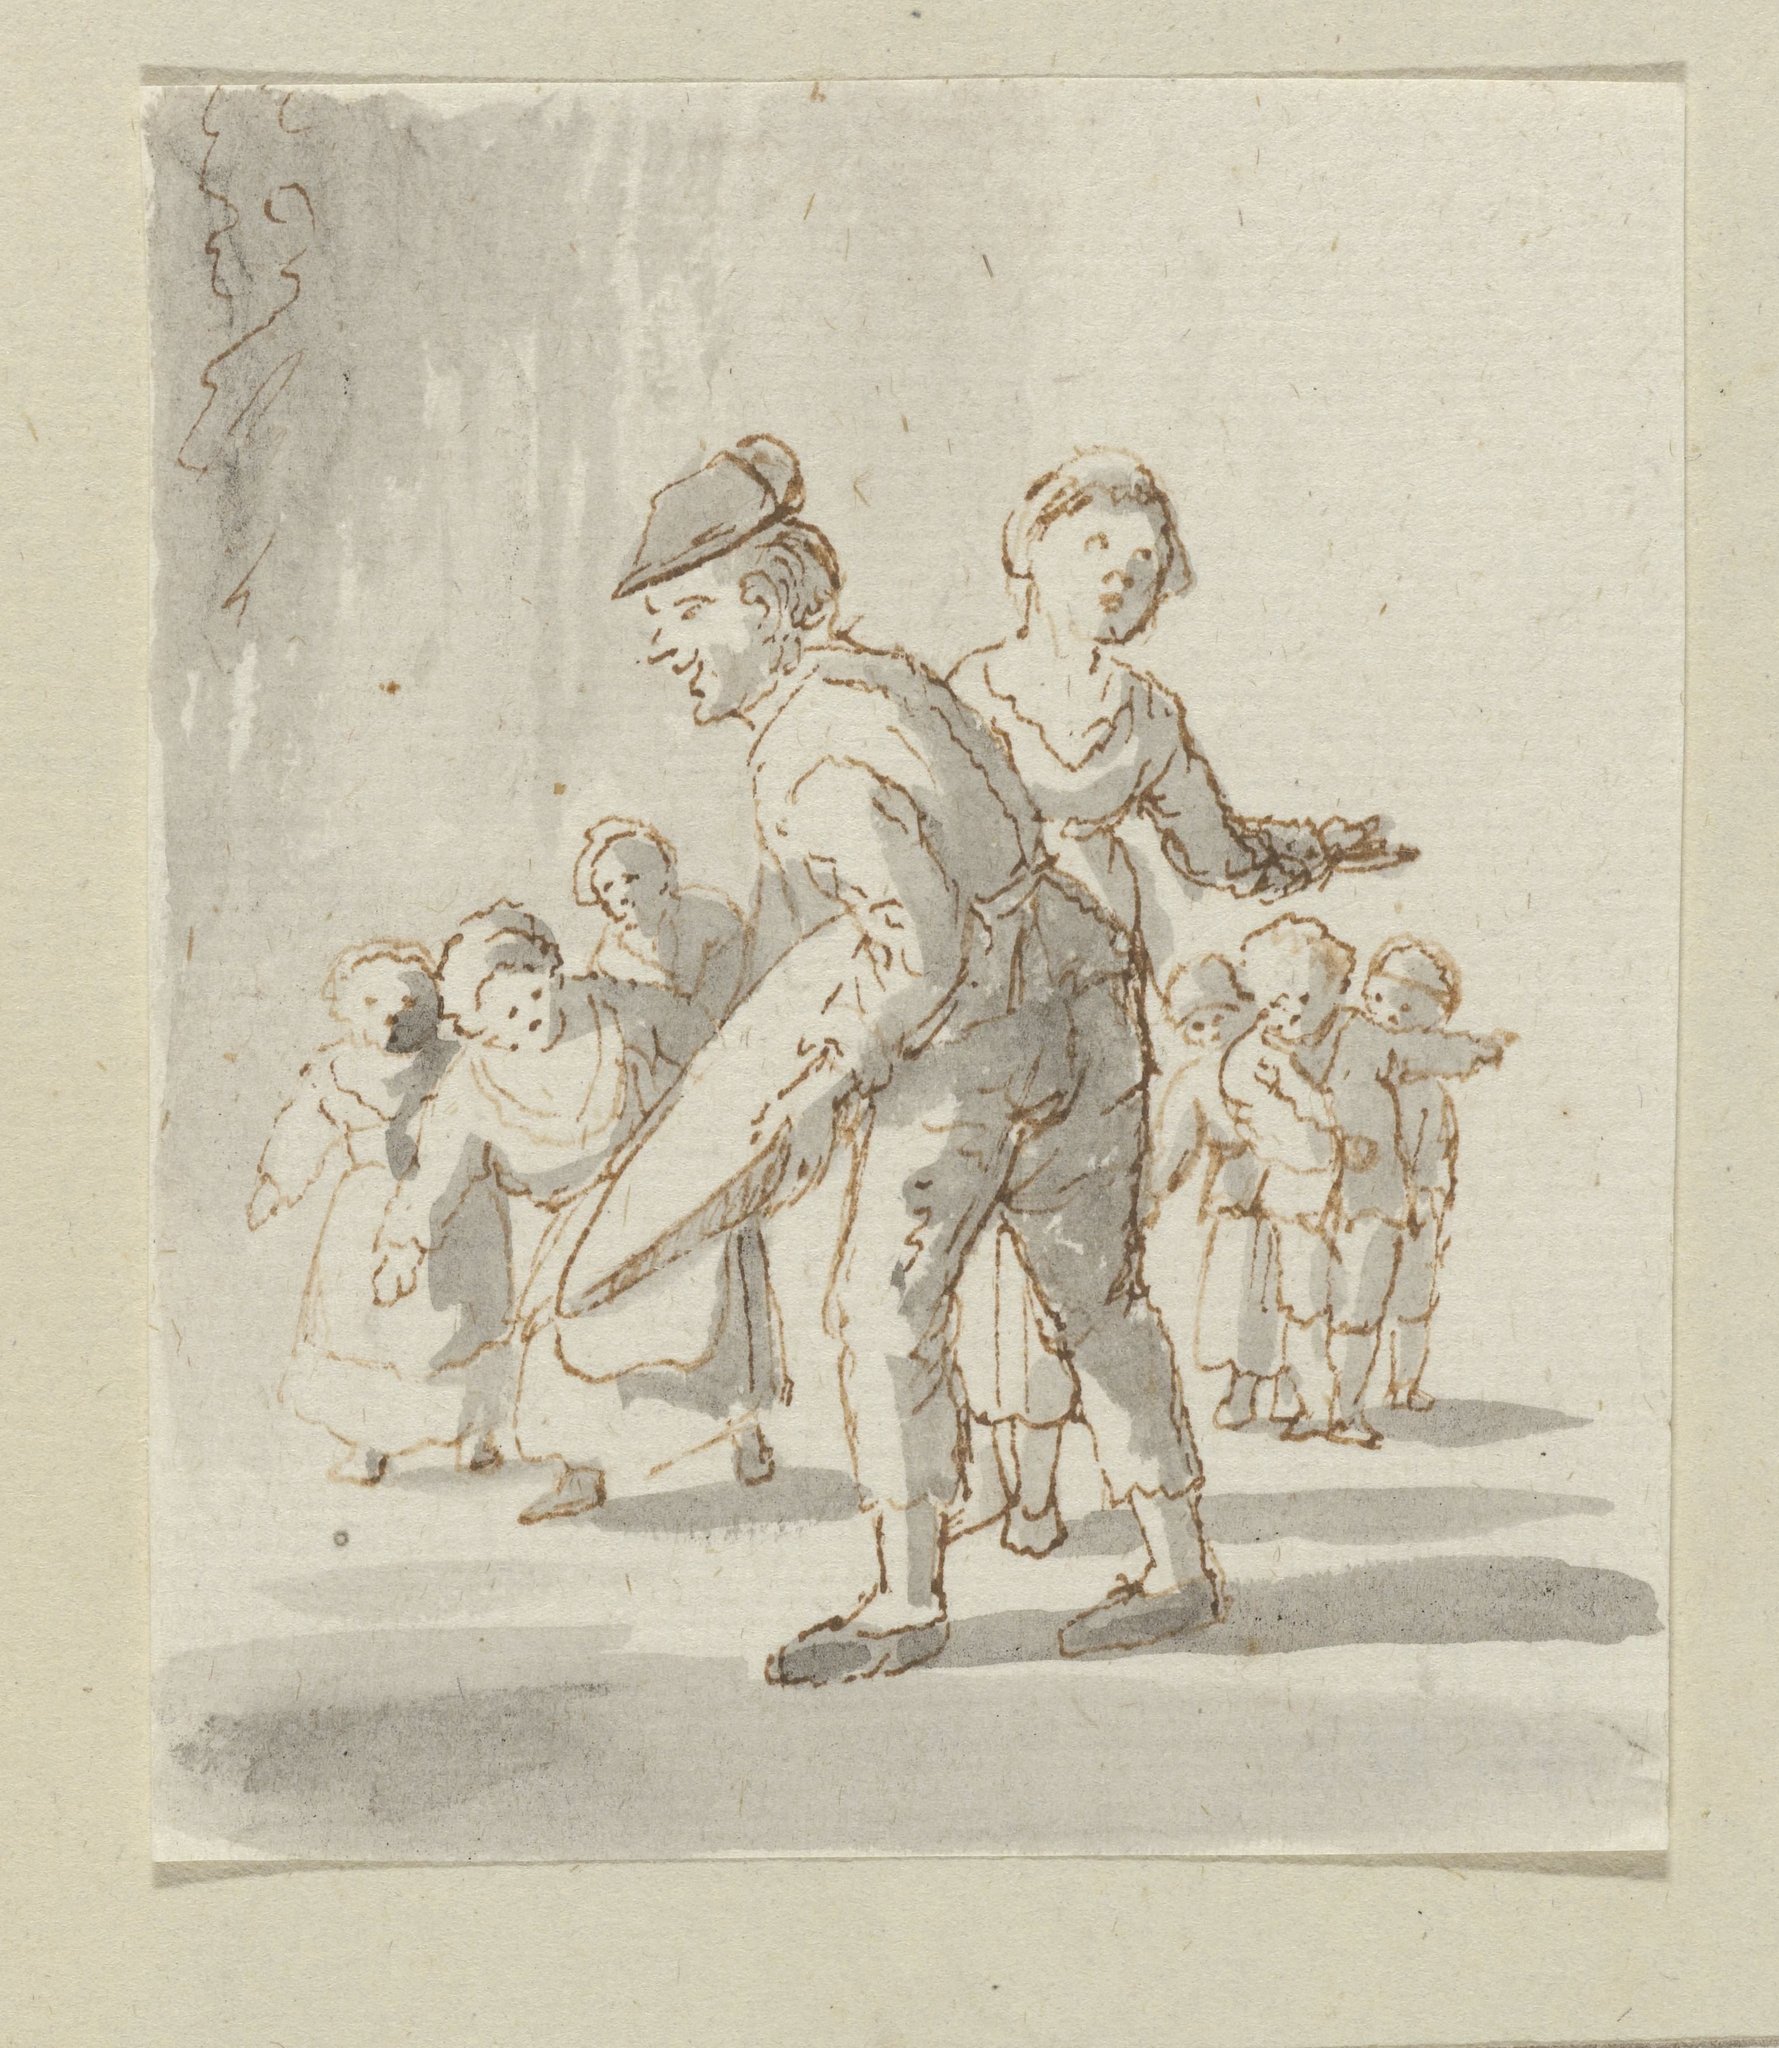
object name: drawing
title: Man en vrouw met groep van zes kinderen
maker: Anonymous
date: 1700-1799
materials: ink, paper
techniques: brush, pen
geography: netherlands